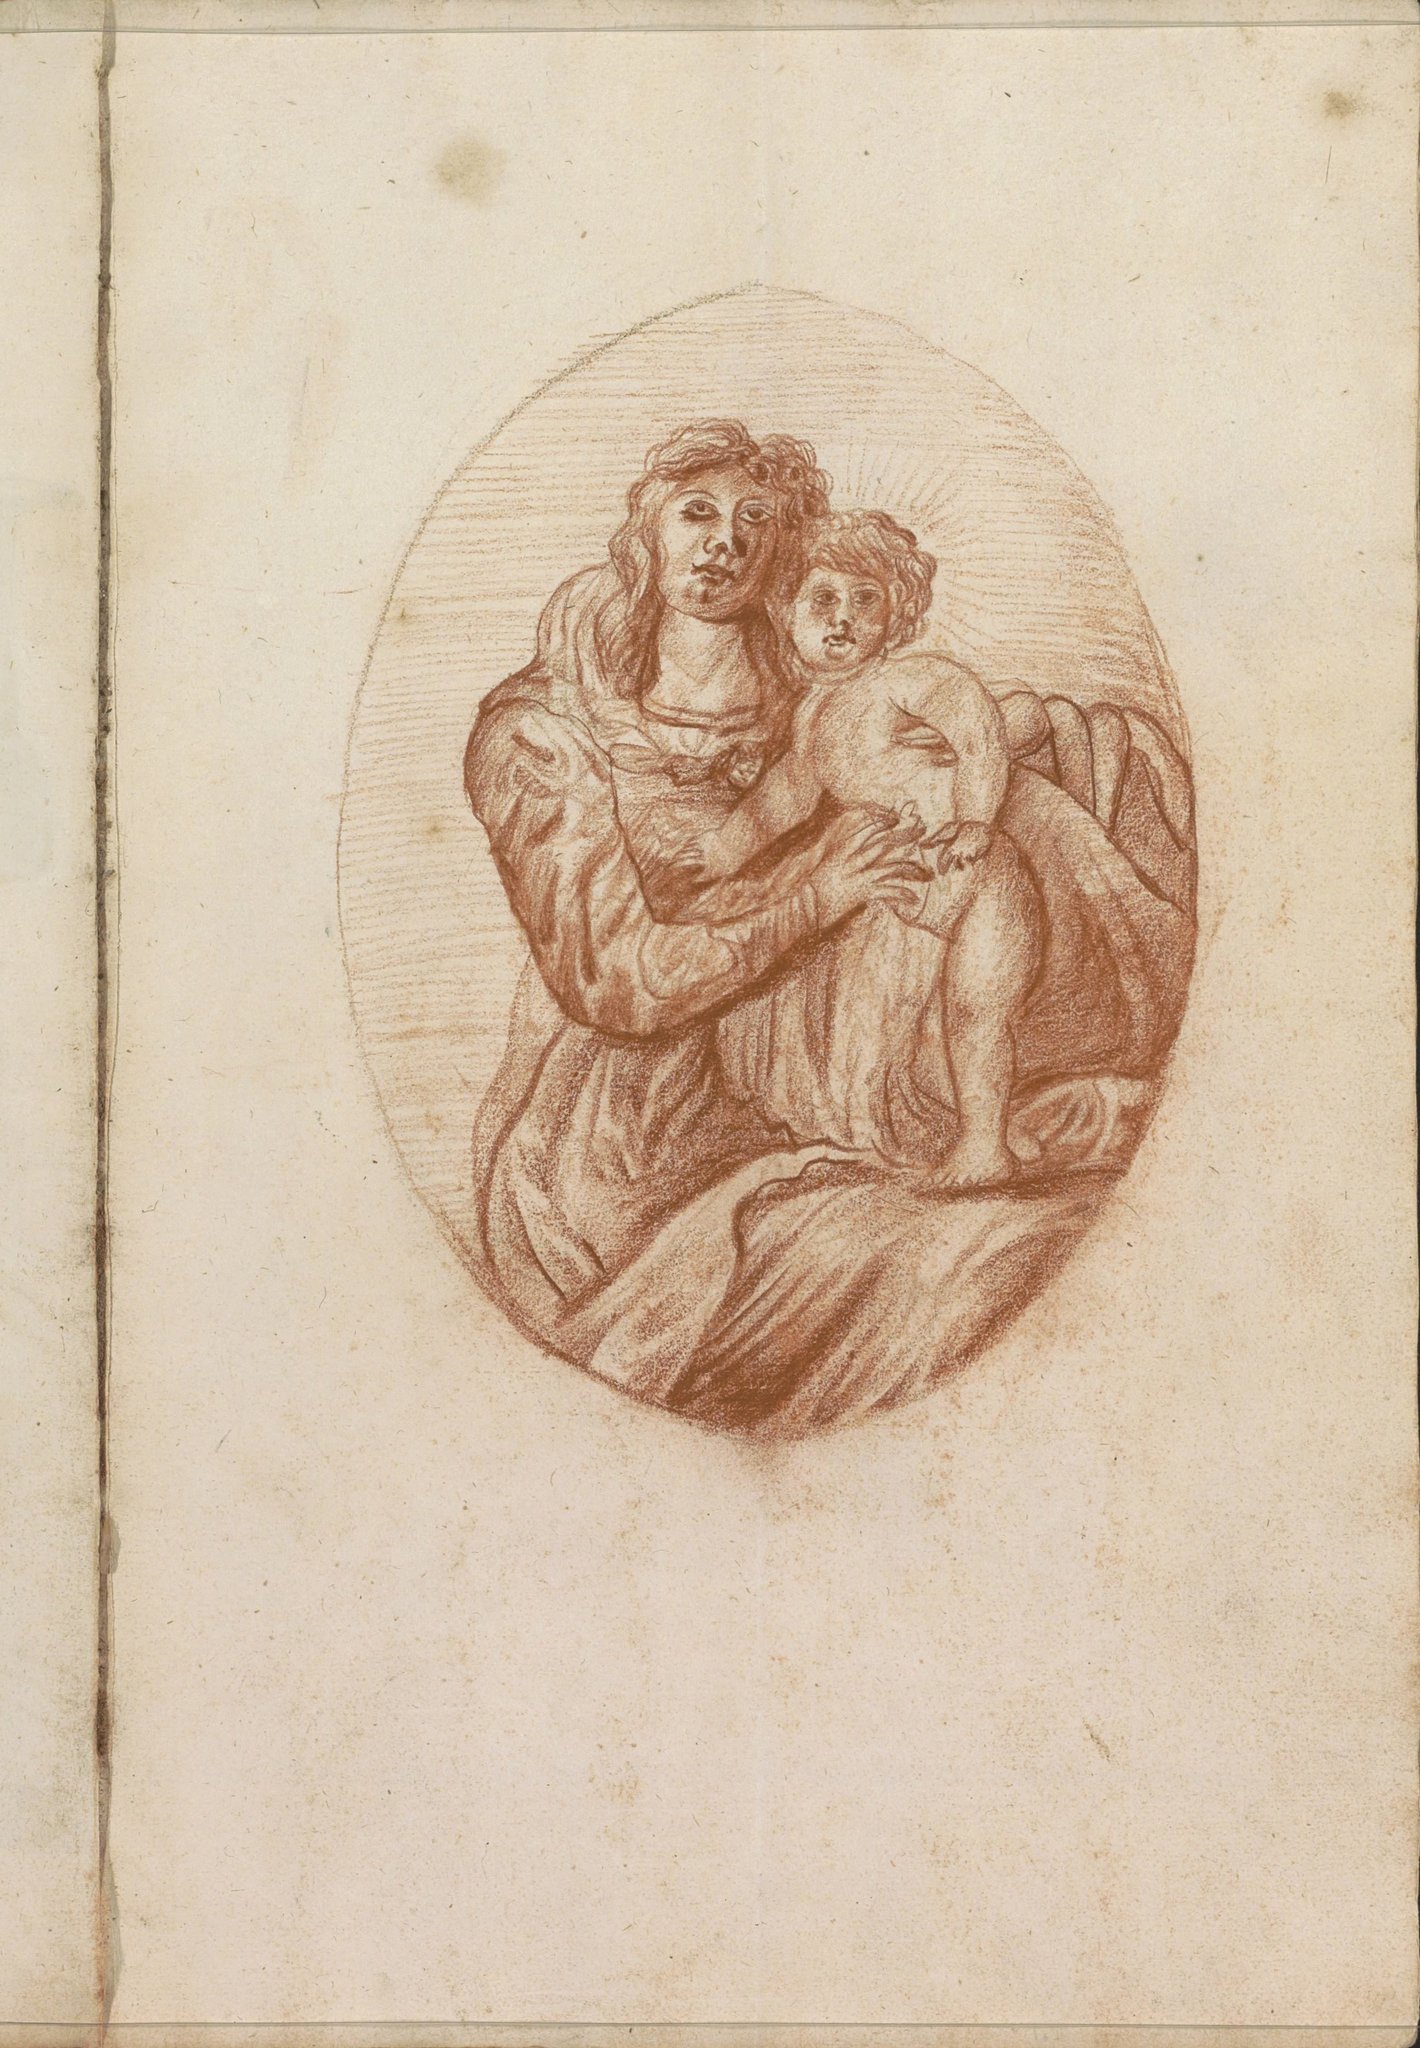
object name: sketchbook leaf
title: Madonna met kind in een ovaal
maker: hendrick van beaumont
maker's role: draughtsman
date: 1696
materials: chalk, paper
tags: madonna: i.e. mary with the christ-child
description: Blad 46 recto uit een schetsboek met 91 bladen.